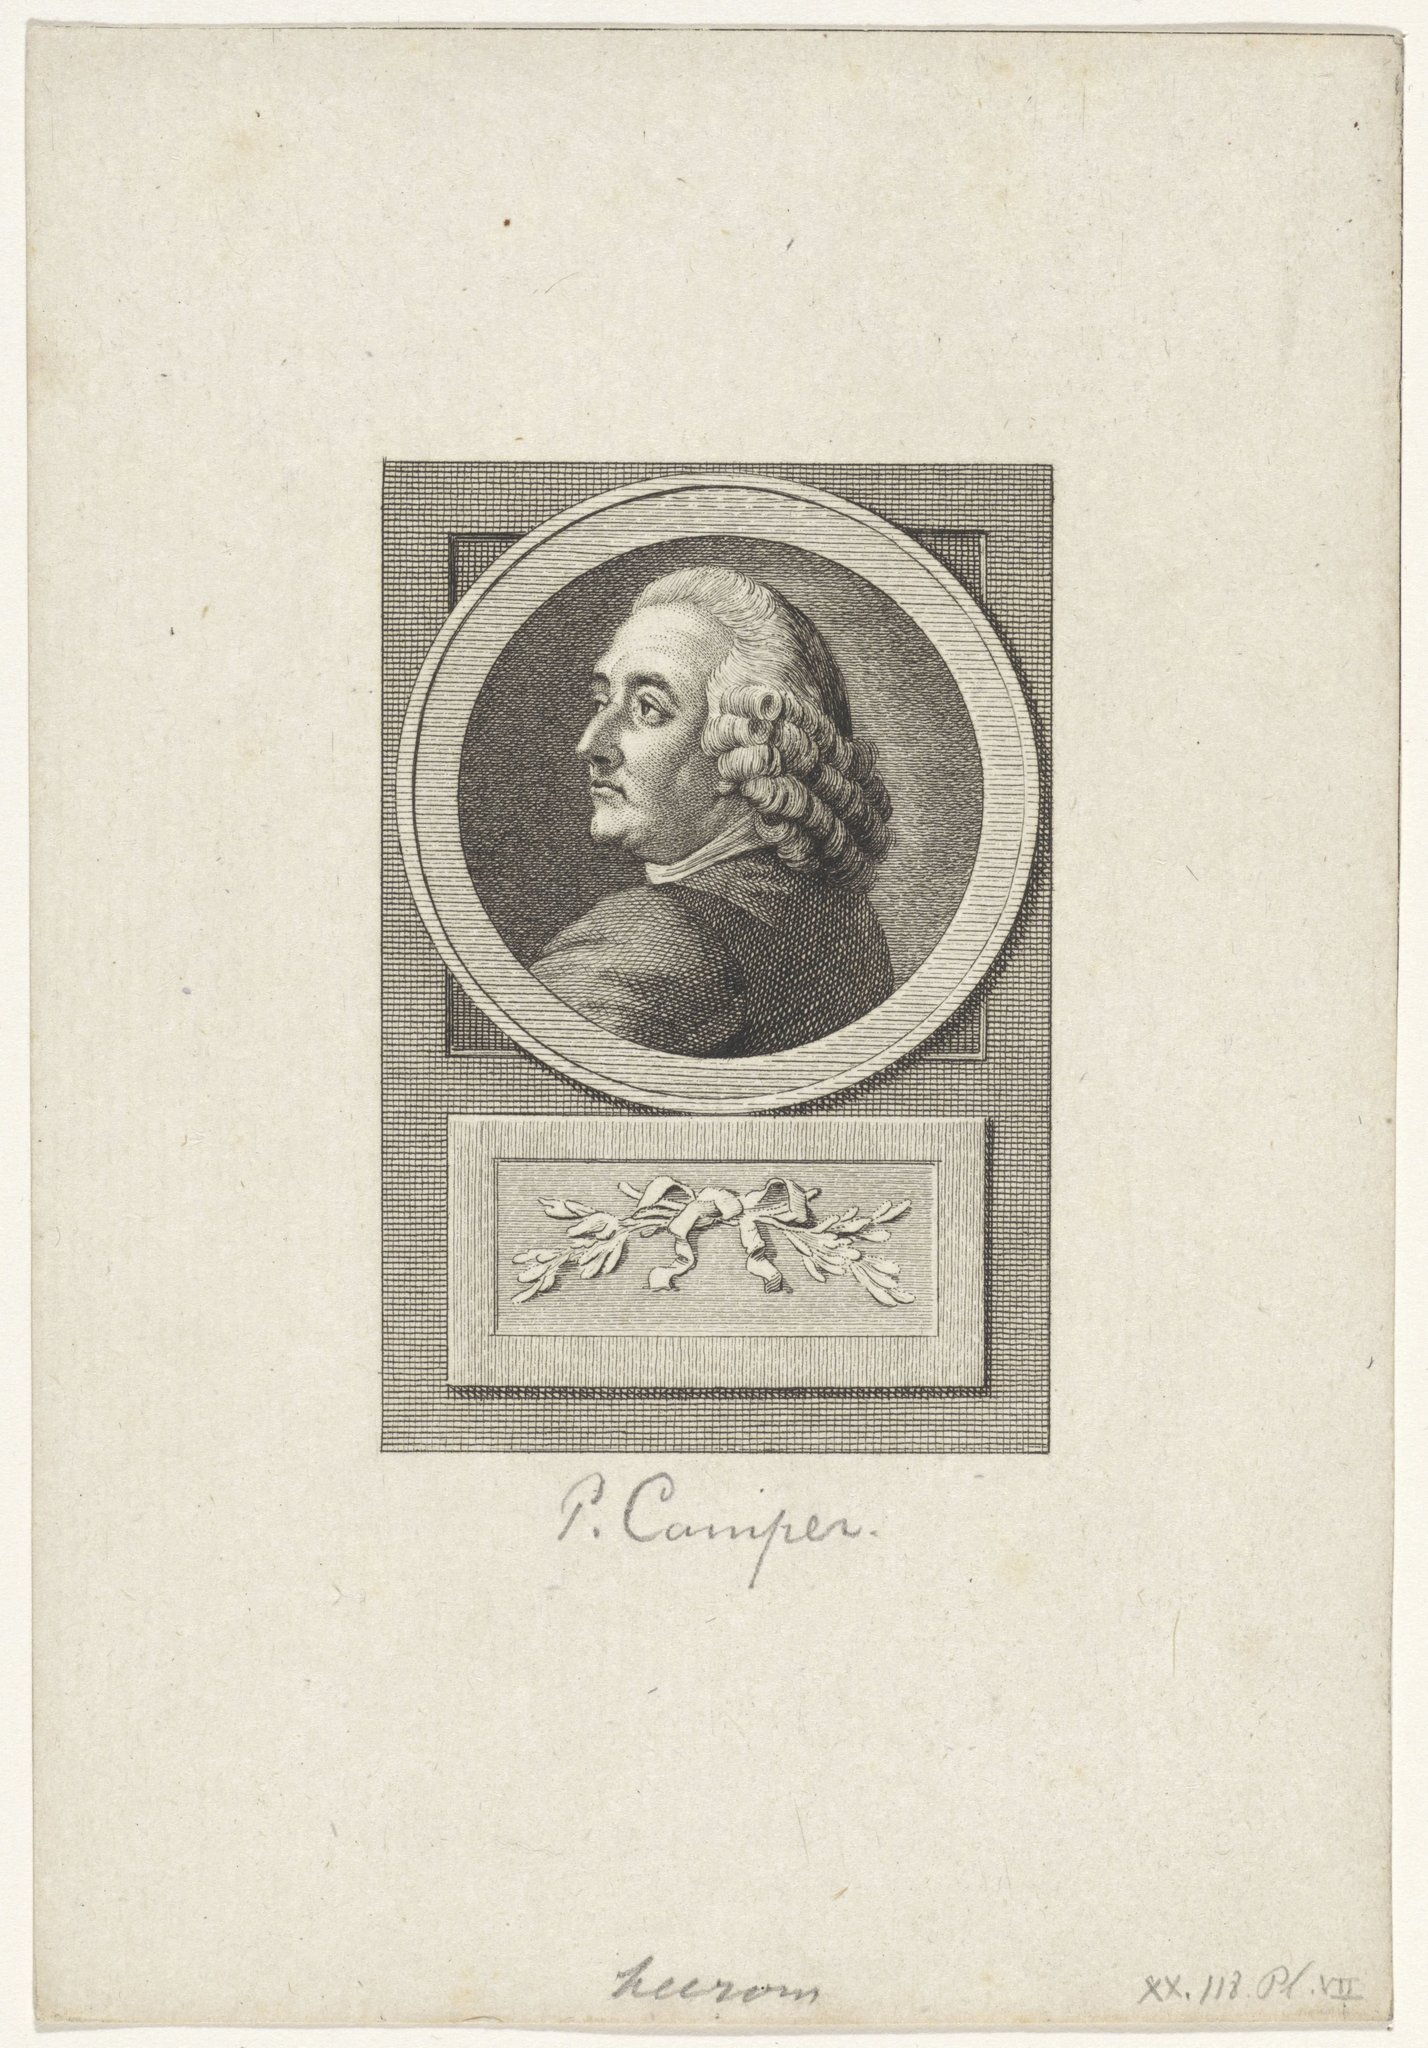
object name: print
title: Portret van Petrus Camper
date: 1783-1795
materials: paper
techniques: engraving, etching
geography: amsterdam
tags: leiden, the hague, petrus camper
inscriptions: collector's mark: Lugt 2228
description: Latere staat prent gebruikt in: Fokke, Jan. Geschiedenissen der Vereenigde Nederlanden voor de vaderlandsche jeugd Ie-XXVste deel. Amsterdam: Johannes Allart, 1783-1795. Deel XX.